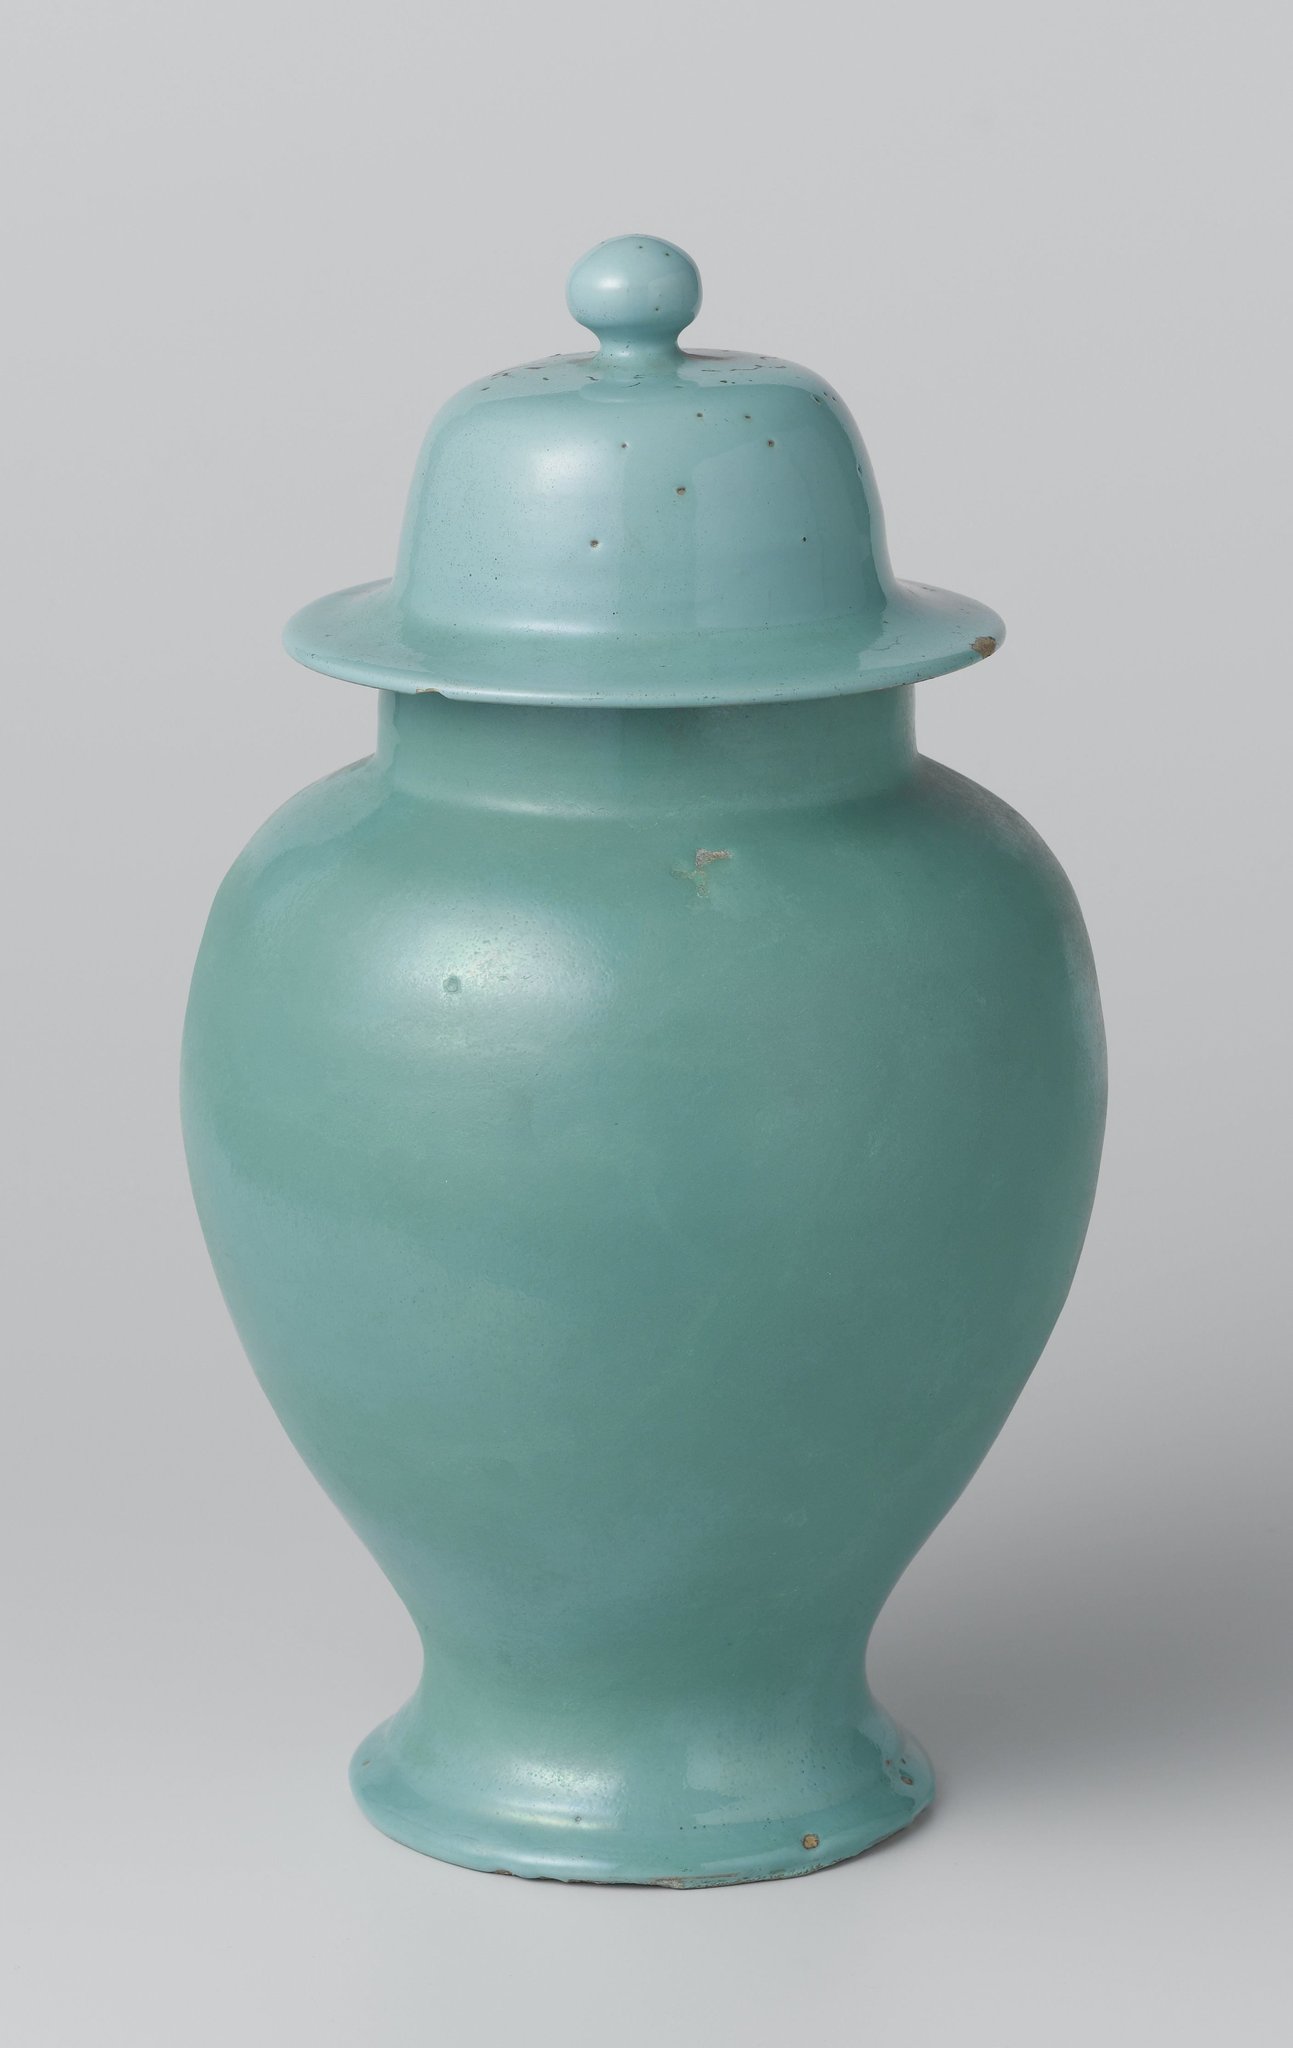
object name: vase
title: Vaas van faience met blauwgroen fond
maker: Anonymous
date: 1700-1750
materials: earthenware, glaze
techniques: painted, polychromy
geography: delft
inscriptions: label: ‘N. 32’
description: Beker van veelkleurig beschilderde faience op een blauwgroene fond, met een deksel. De beker is onderdeel van een stel.